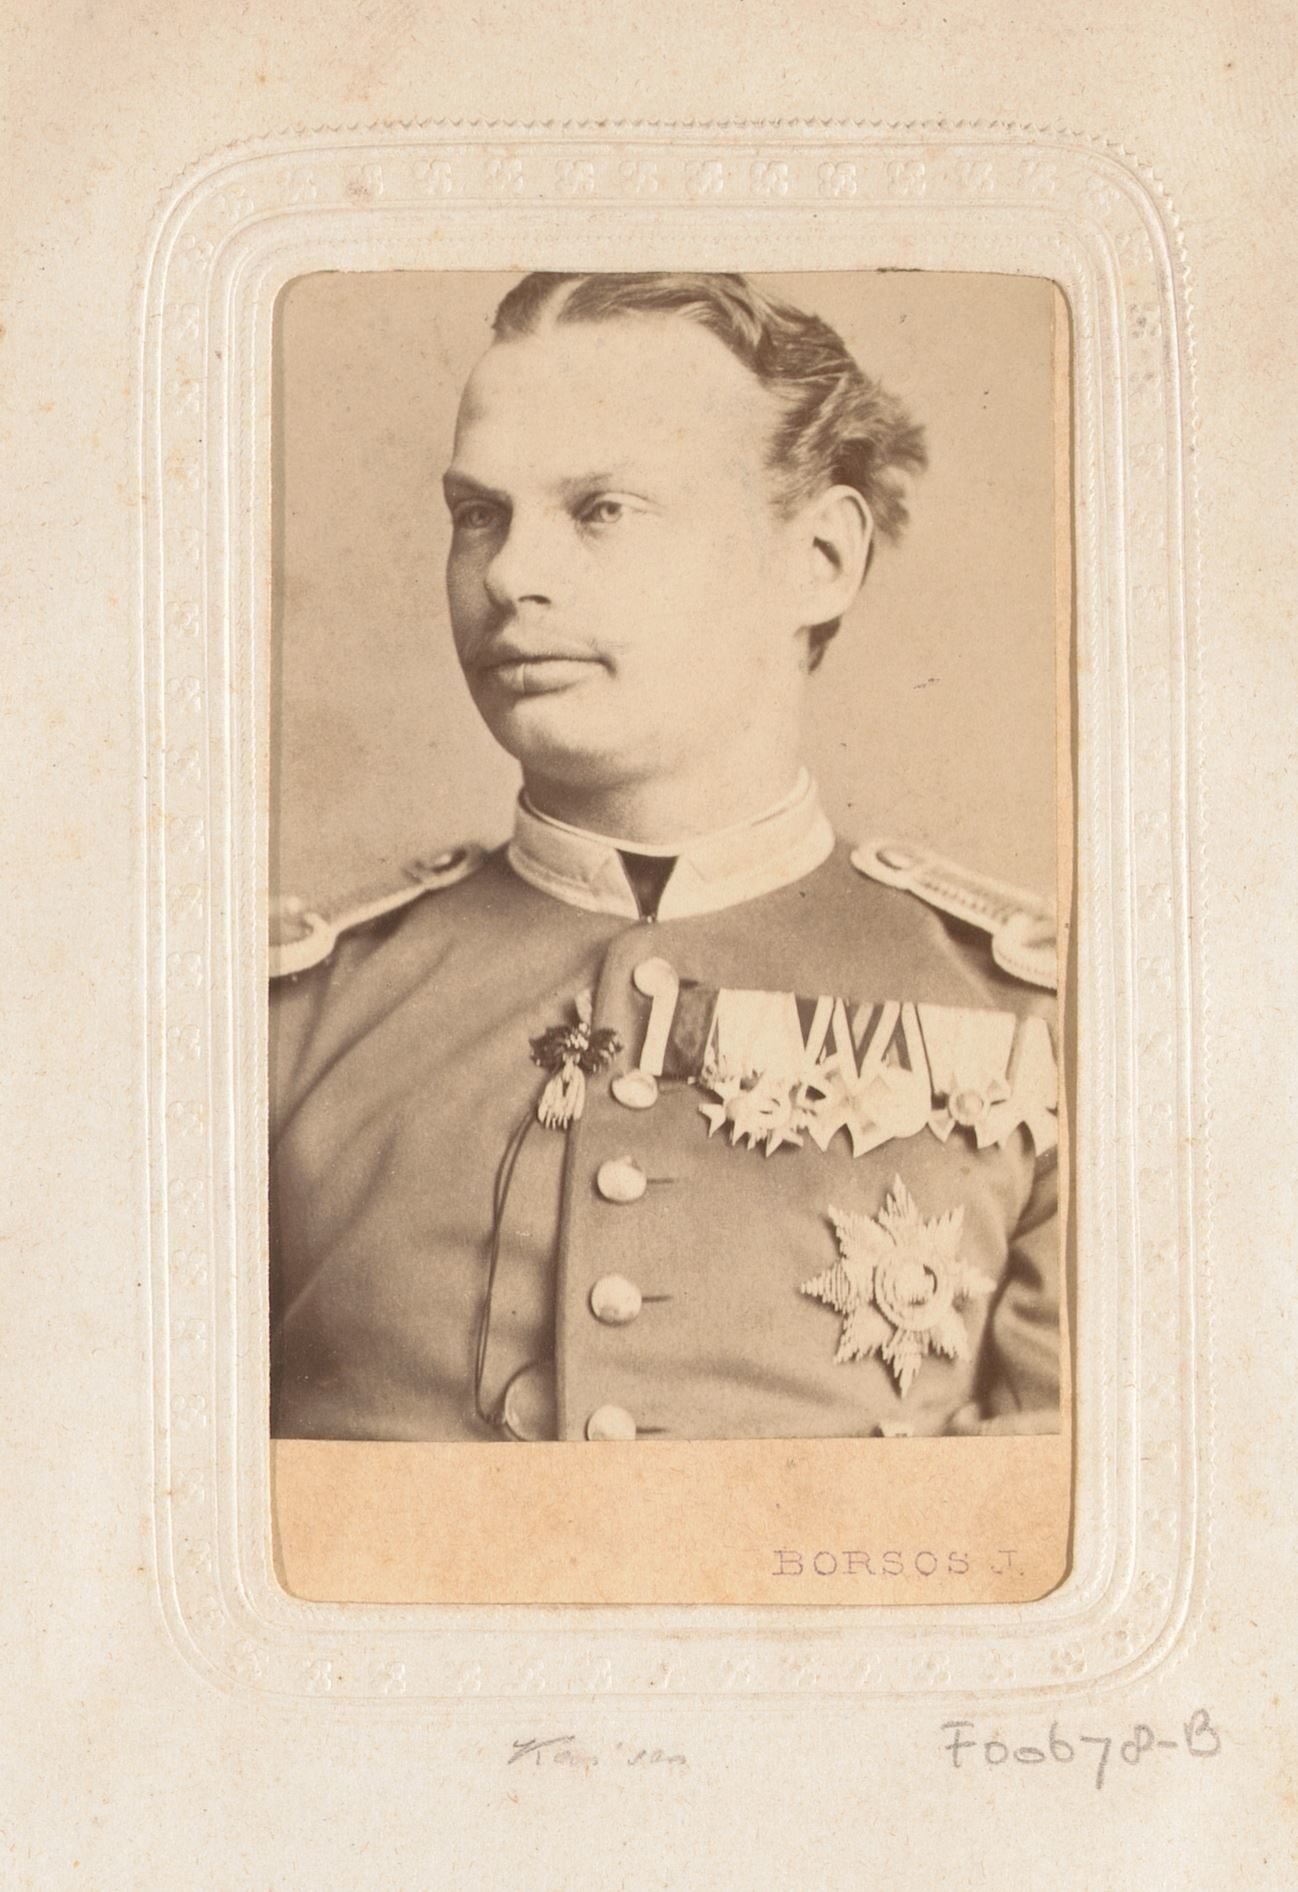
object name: carte de visite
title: Portret van Frans Jozef I van Oostenrijk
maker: josef borsos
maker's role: fotograaf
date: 1860-1880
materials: cardboard, photographic support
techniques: albumen print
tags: historical persons, emperor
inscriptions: annotation: ‘Kais von’